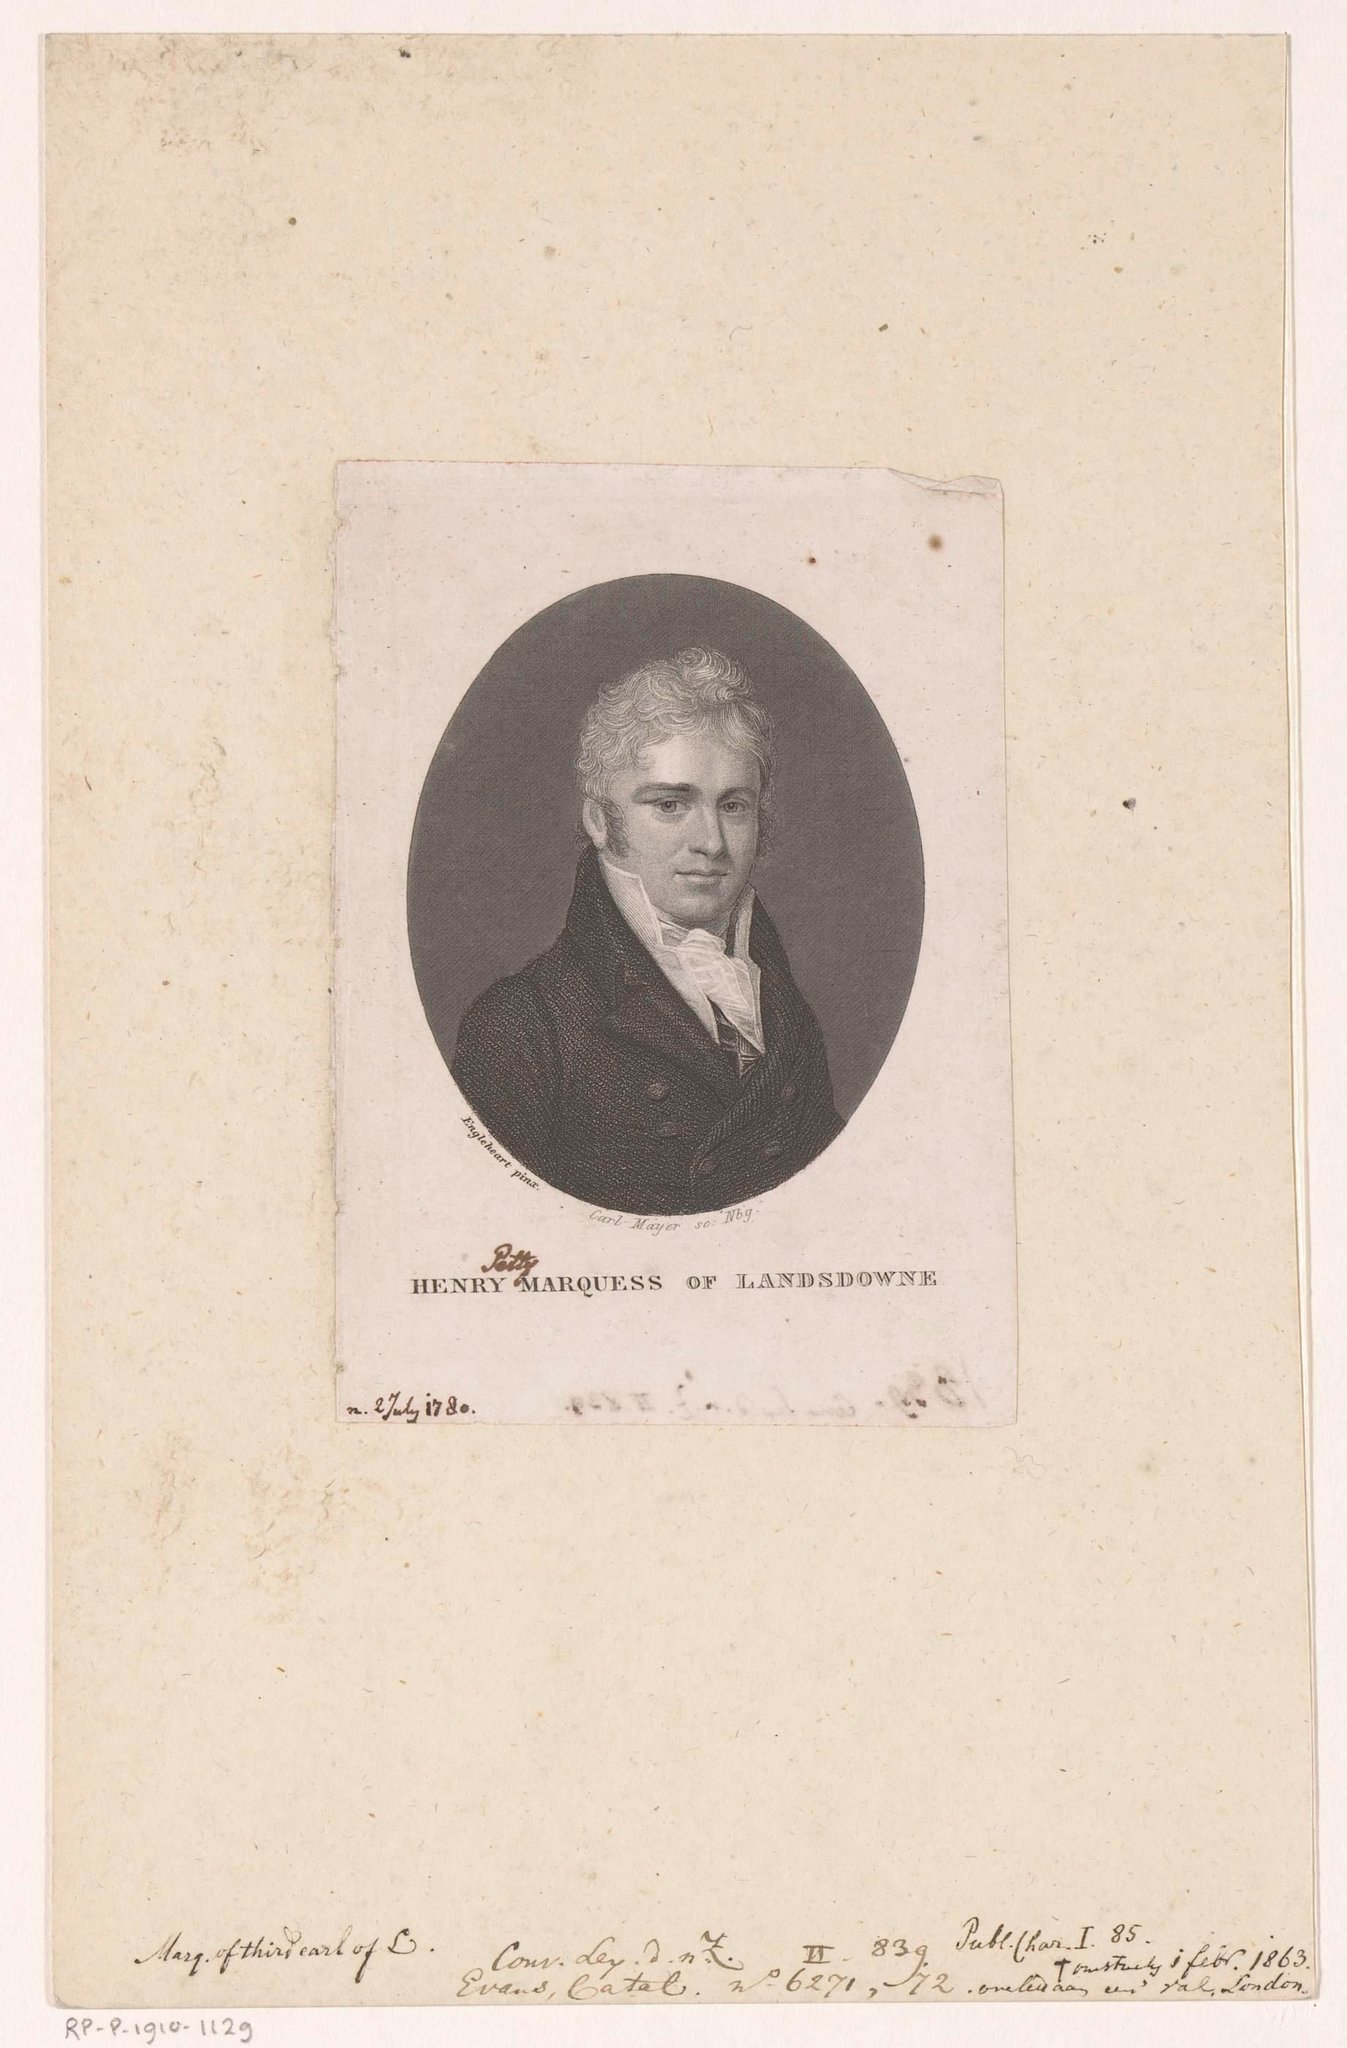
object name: print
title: Portret van Henry Petty-Fitzmaurice, 3rd Marquess of Lansdowne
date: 1808-1868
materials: paper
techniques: engraving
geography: nuremberg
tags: politician, historical persons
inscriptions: collector's mark: Lugt 2228